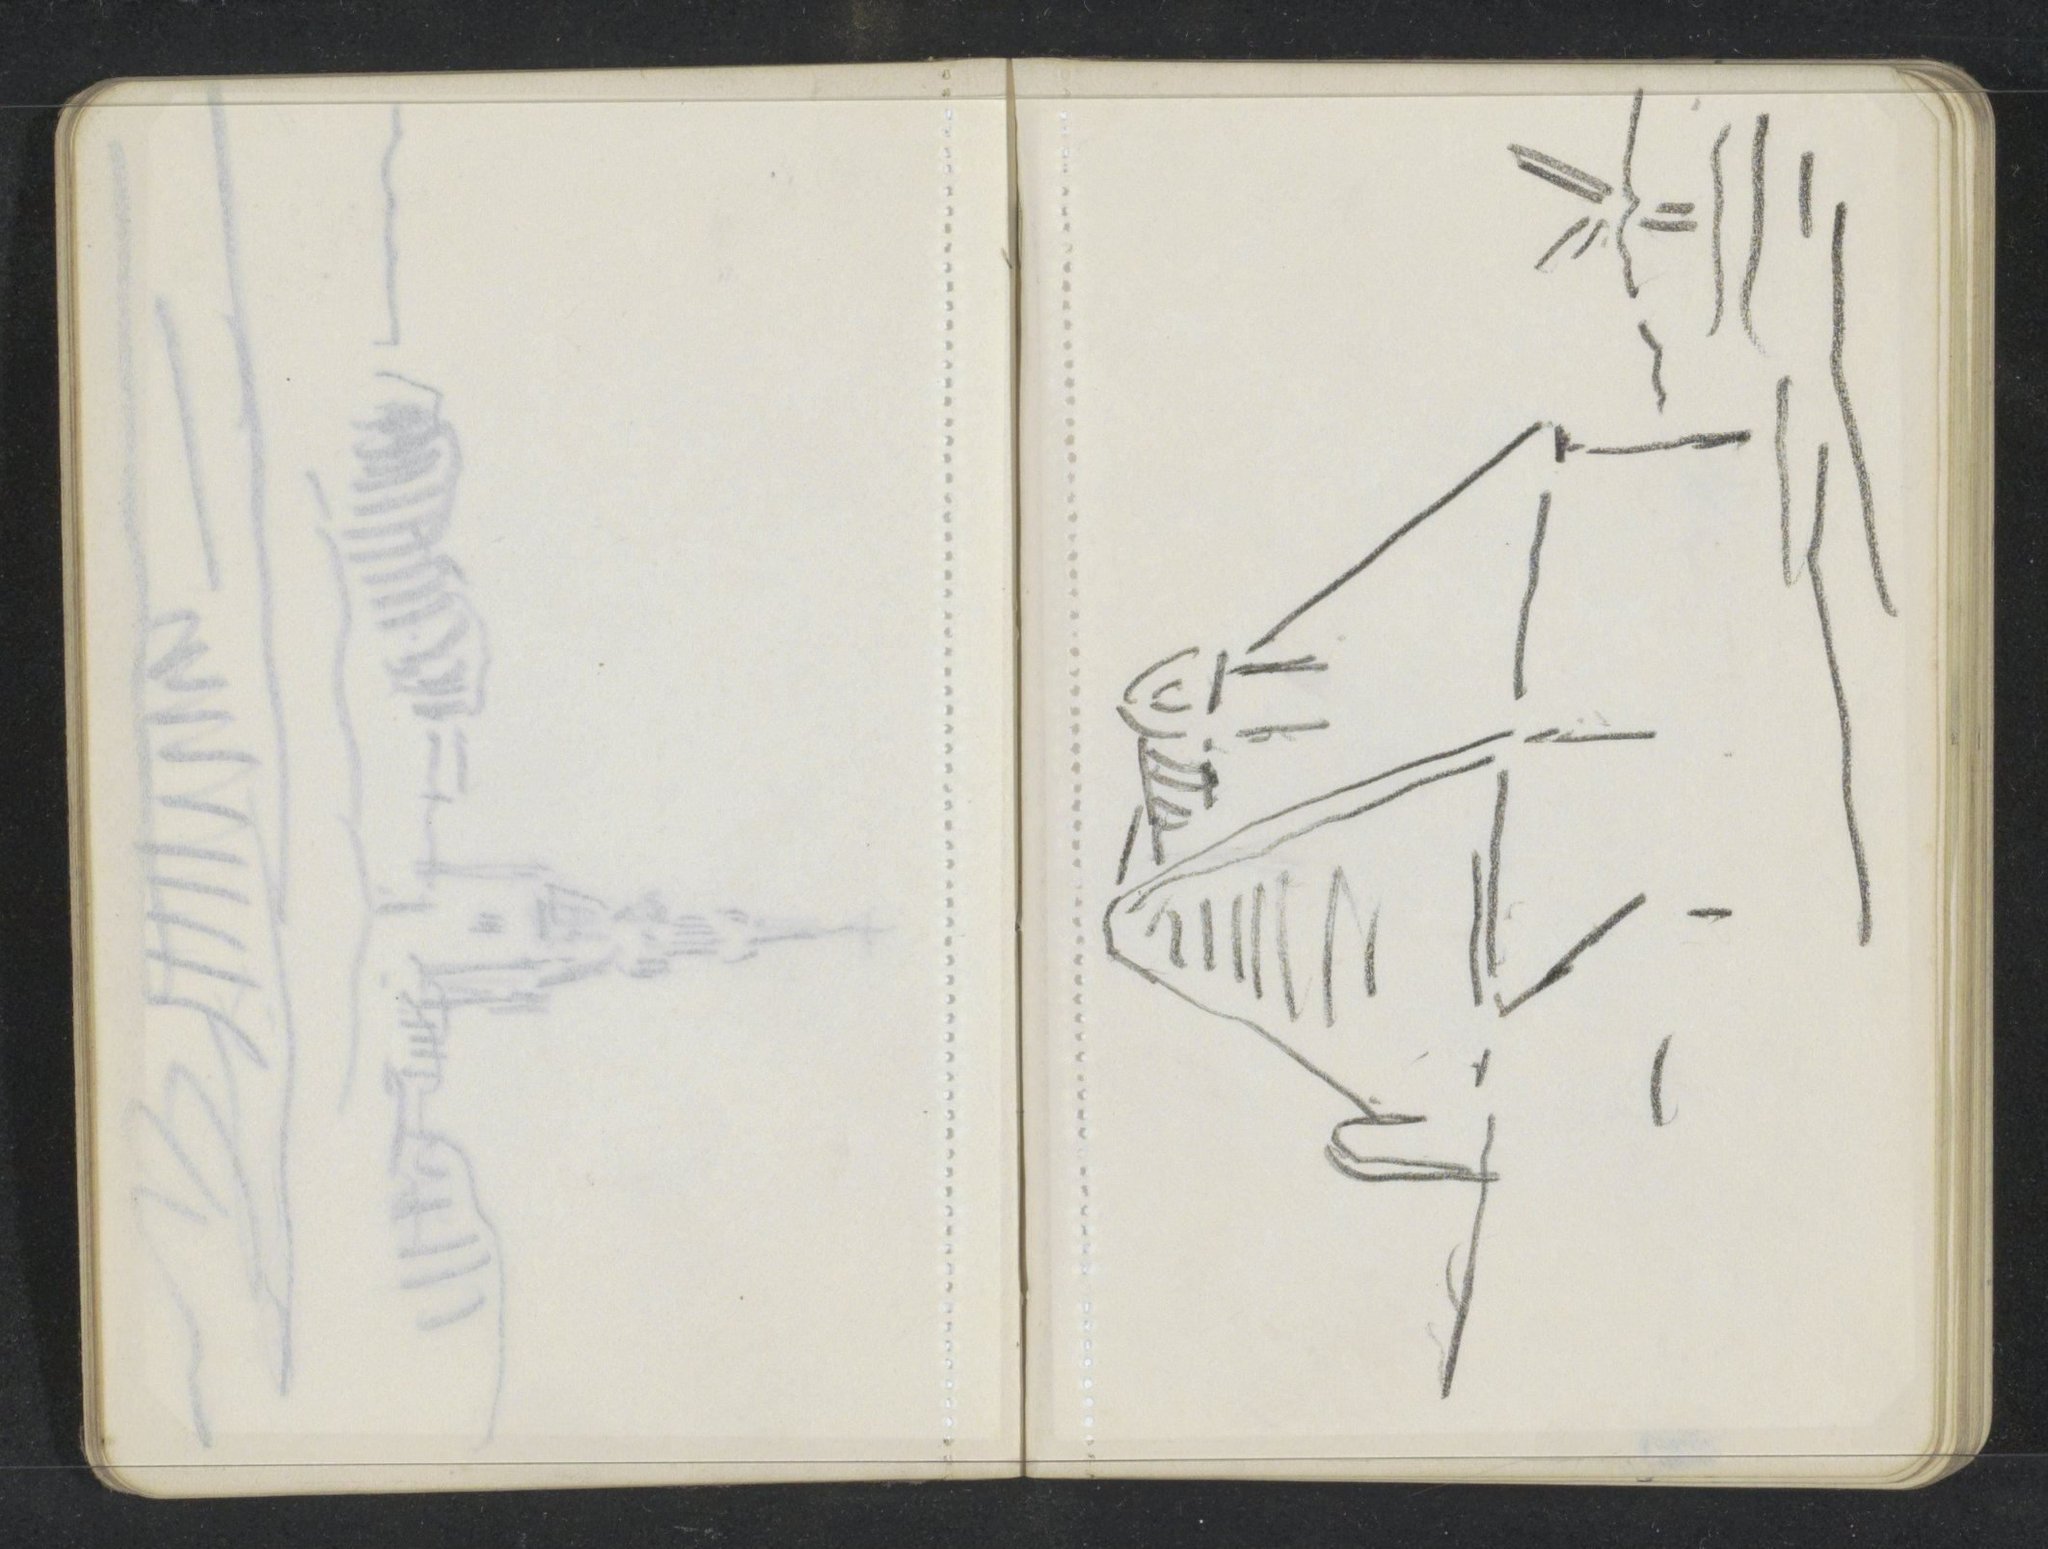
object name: sketchbook leaf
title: Huis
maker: alexander shilling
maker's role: draughtsman, print maker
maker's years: 1859-1937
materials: chalk, paper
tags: the usual house or row of houses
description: Blad 16 recto uit een schetsboek met 91 bladen.